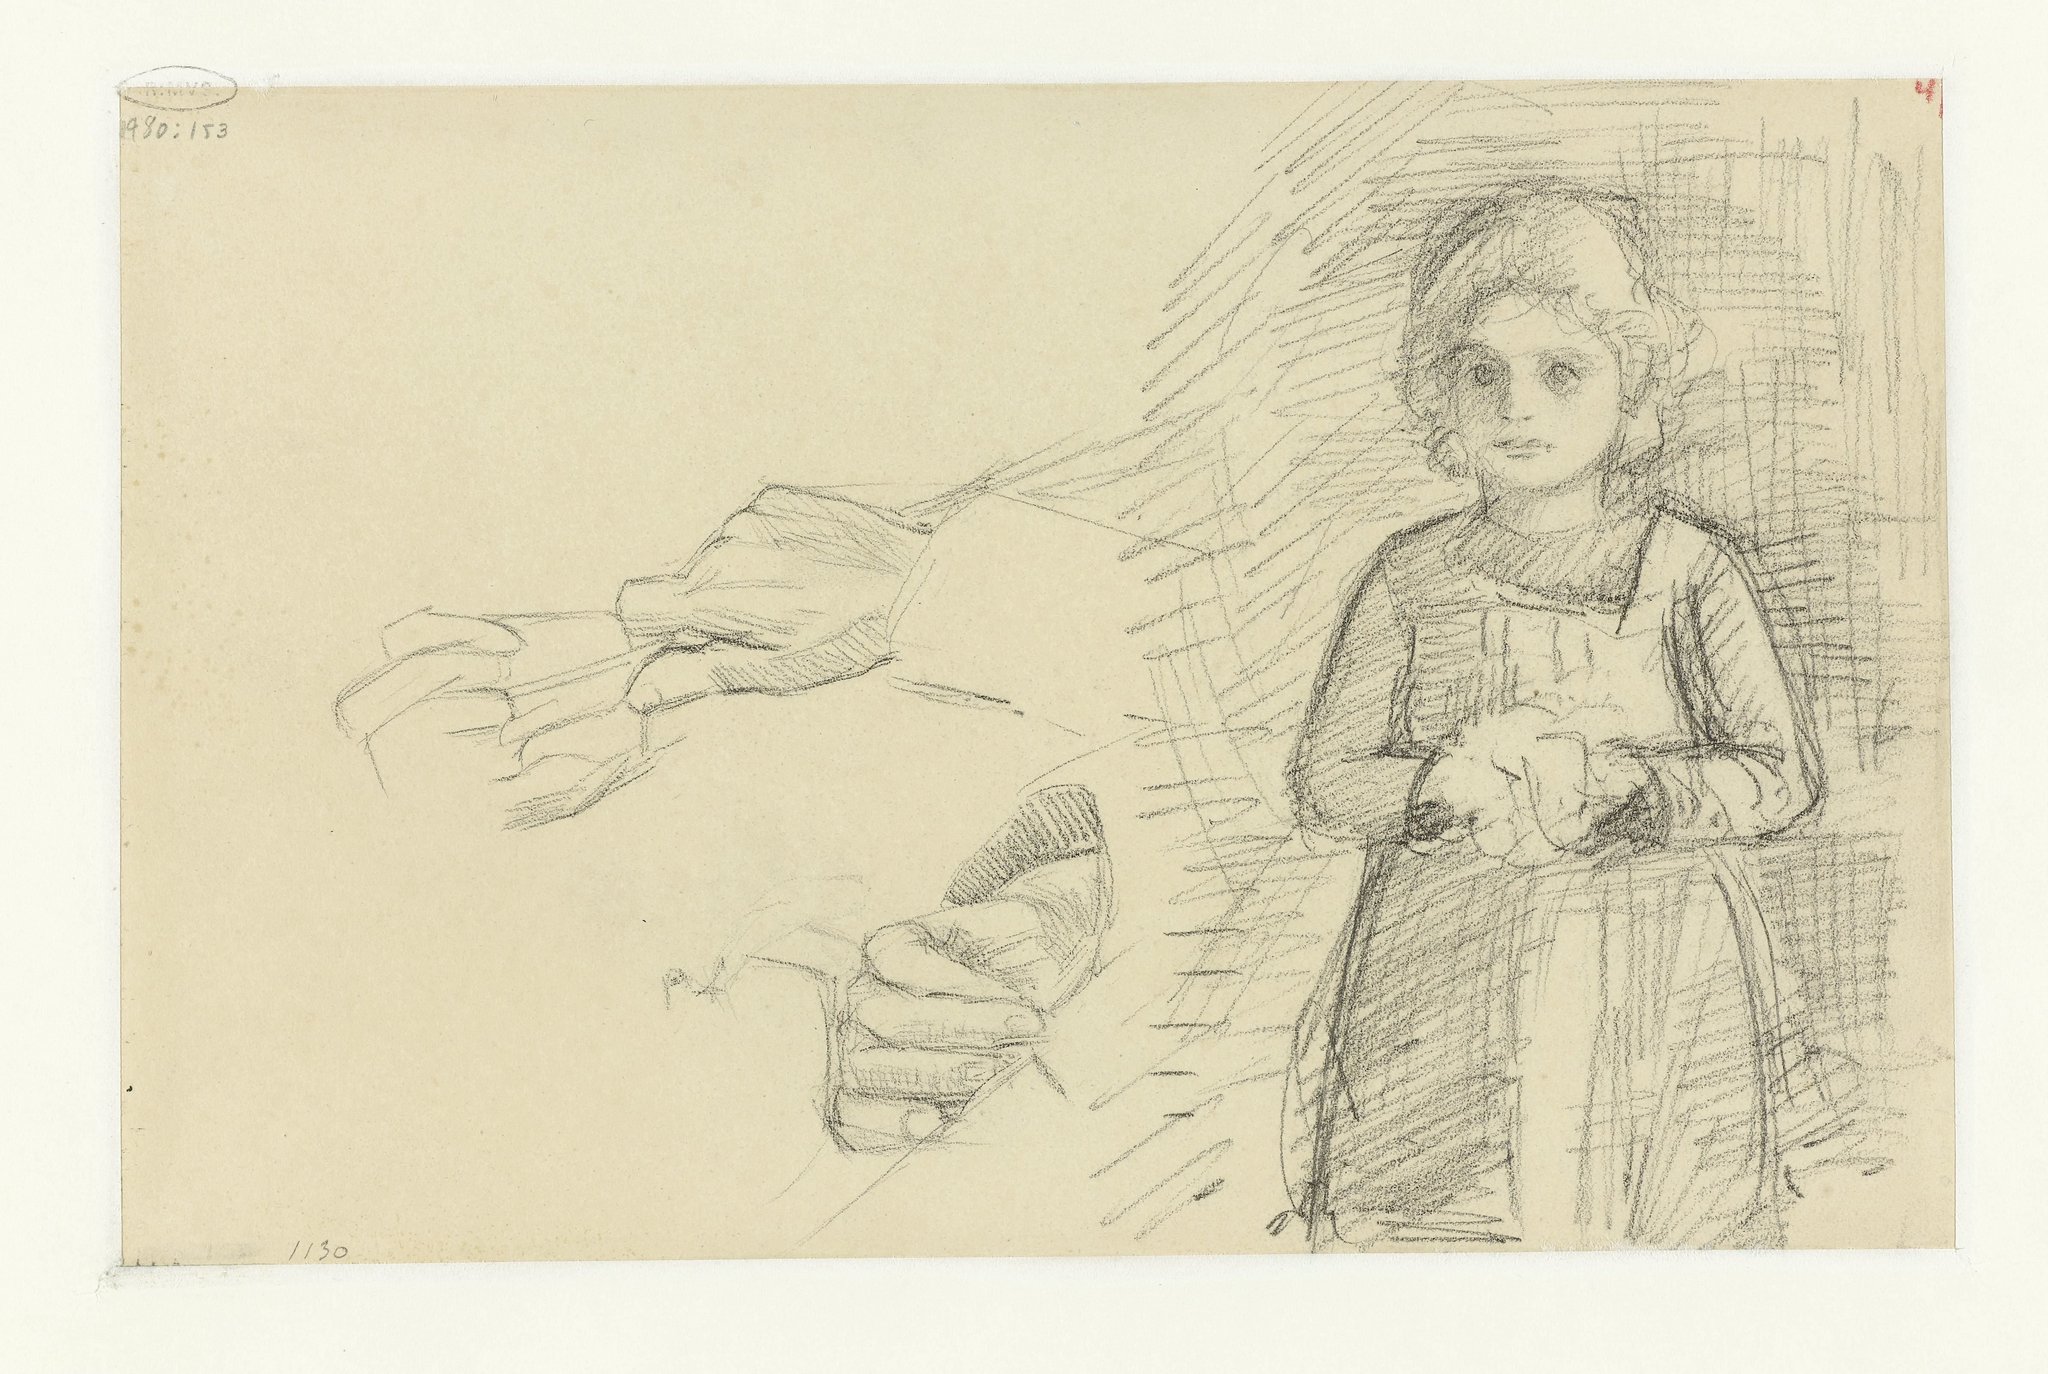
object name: drawing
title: Studie van een staand kind en handen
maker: jozef israëls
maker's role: draughtsman, painter, print maker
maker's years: 1824-1911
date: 1834-1911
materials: chalk, paper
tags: hand